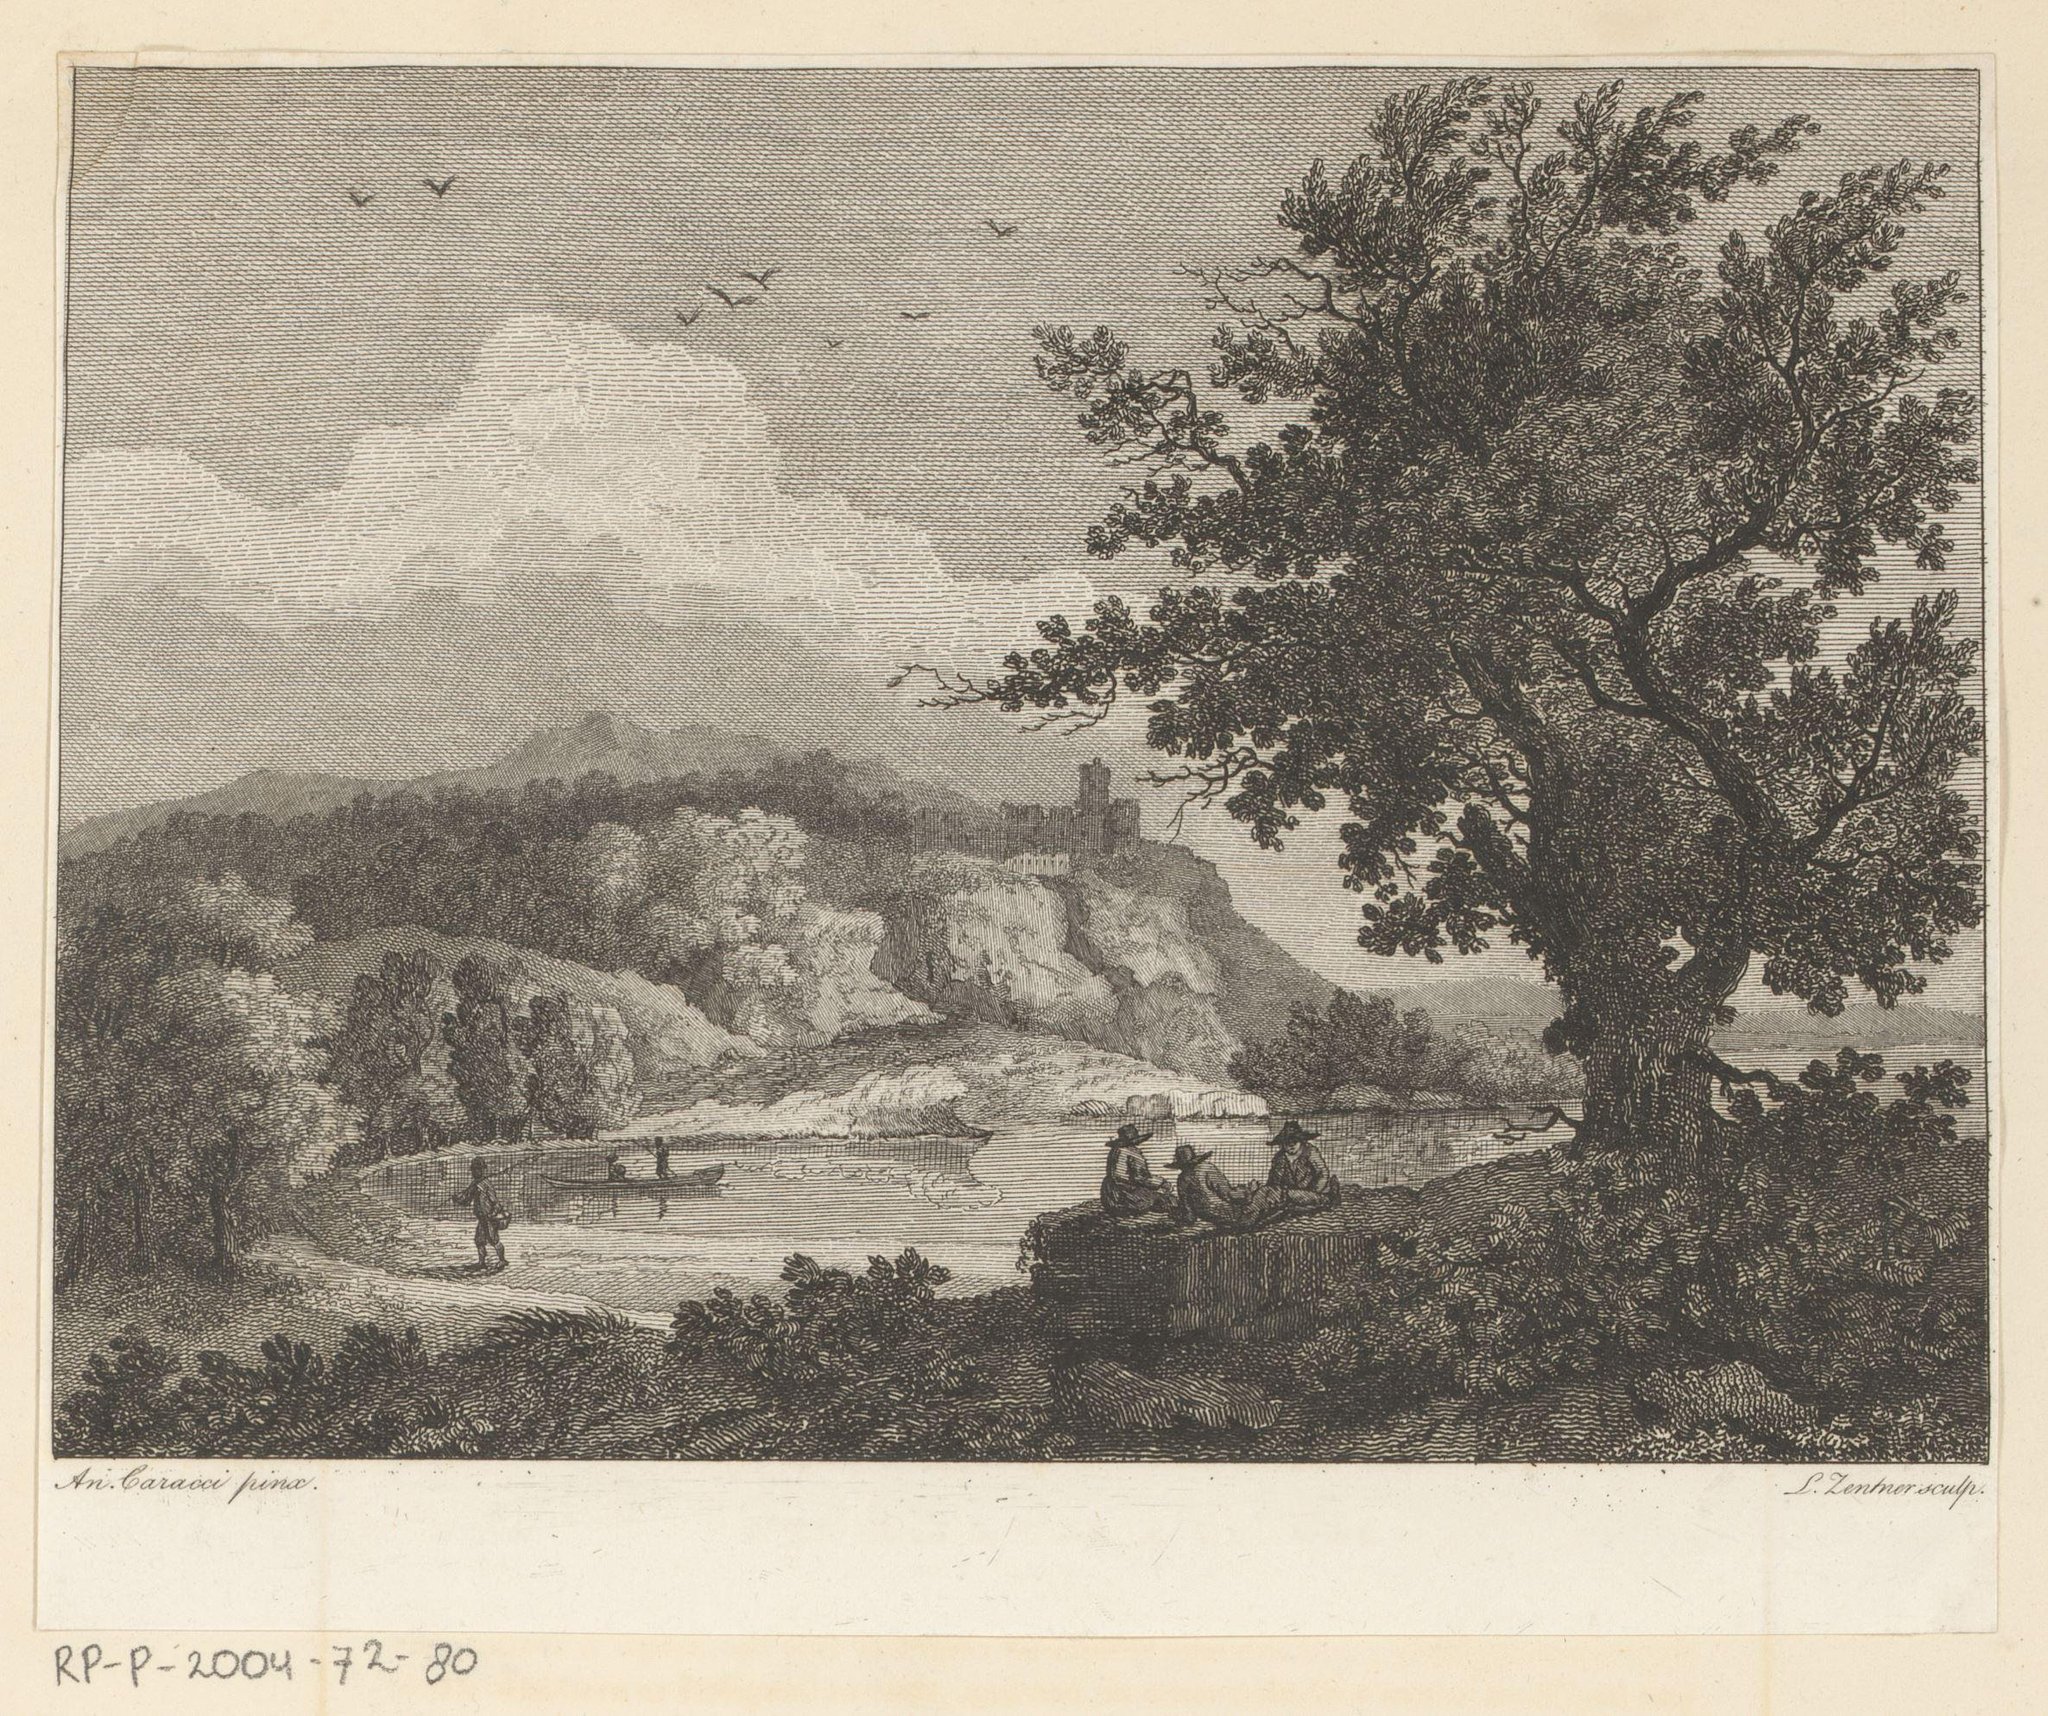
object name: album leaf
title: Landschap met figuren bij een meer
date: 1791-1798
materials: paper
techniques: engraving, etching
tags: lake (+ landscape with figures, staffage)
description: Prent uit: Zentner, J.L.L.C.. A select Collection of landscapes, from the best old masters, one of each engraved by L. Zentner, after drawings made by him from original pictures (...). Londen: J. Thane, [1791-1798]. De samensteller heeft deze prent in het album geplakt als illustratie bij: Pilkington, Matthew en Johann Heinrich Füssli. A dictionary of painters, from the revival of the art to the present period. 4 dln. Londen: John Crowder, 1805, dl. 1, p. 104.